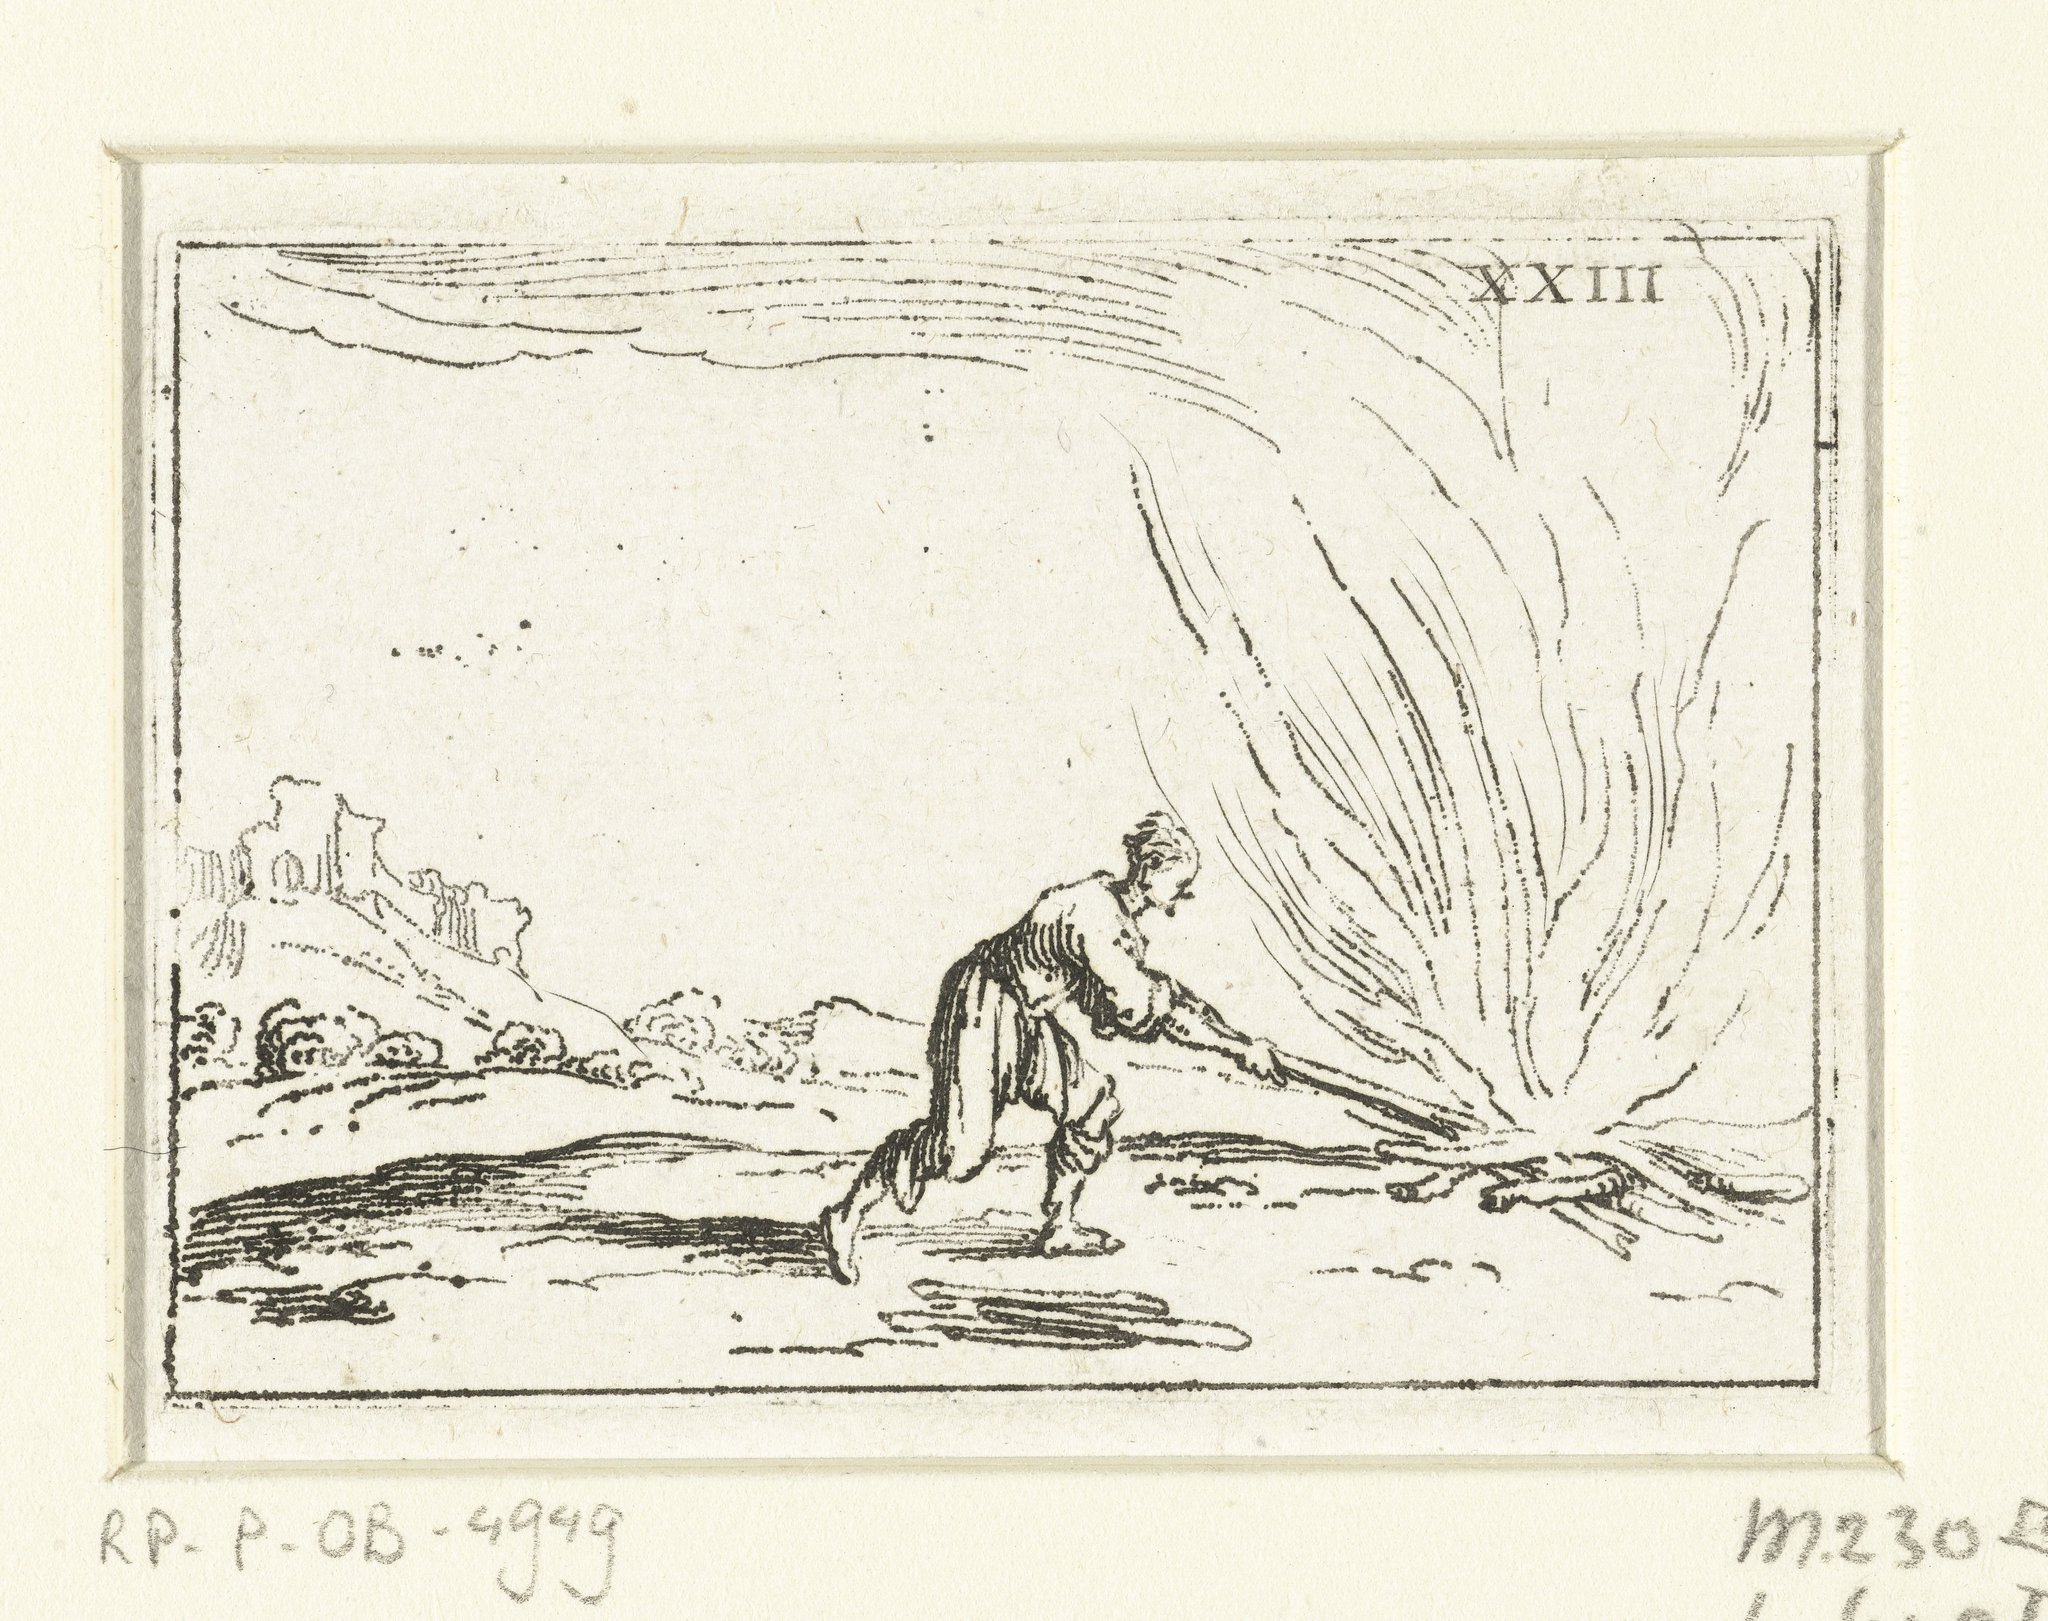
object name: print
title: Leven van Maria in emblemen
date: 1625-1629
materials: paper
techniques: etching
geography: paris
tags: open fire (in general)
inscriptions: collector's mark: Lugt 240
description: Voorstelling van een man die met een stok een houtvuurtje opport. Dit blad is onderdeel van de embleemserie 'Leven van Maria in emblemen'. De eerste staat van deze serie behelst naast een titelpagina en 26 emblemen ook drie bladen met lofzangen op Maria in boekdruk zonder afbeelding.